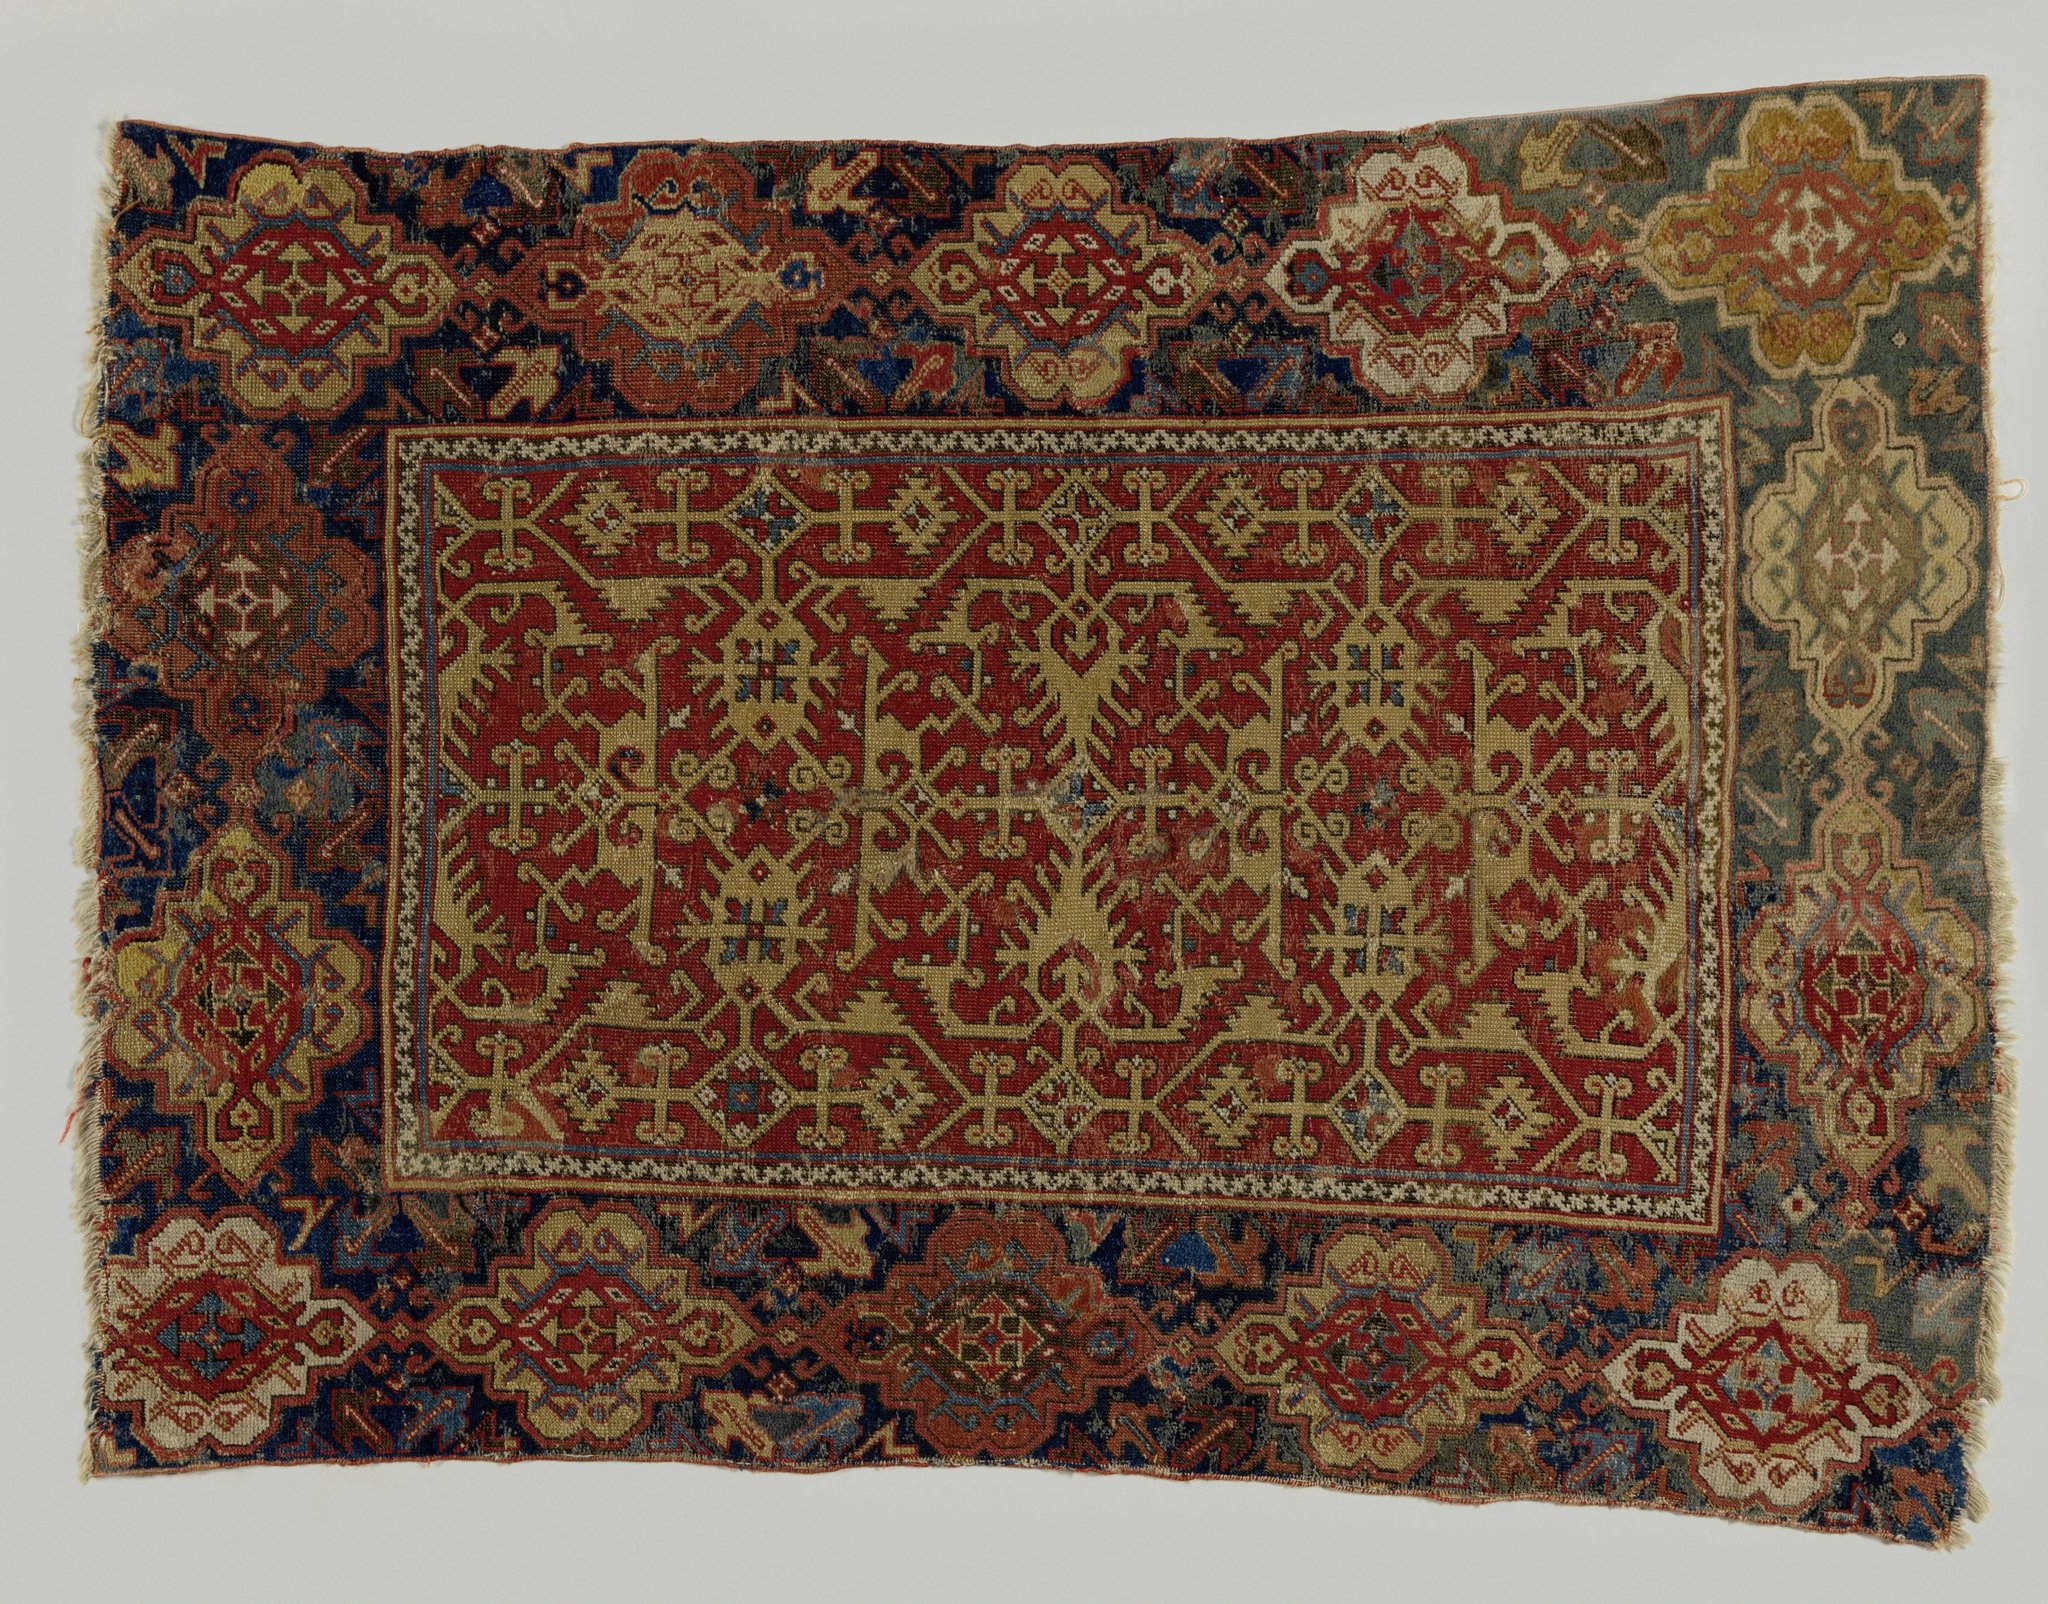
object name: oriental rug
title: Oosters tapijt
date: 1600-1699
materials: wool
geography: asia minor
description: Oosters tapijt, arabeskenkleed, lottotapijt. Middenveld met gele arabeskenmotieven tegen een steenrode achtergrond. Lottopatroon uitgevoerd in de kelim stijl. Tweevoudige rand, waarvan de brede versierd is met gelijkvormige cartouches. Knoop: Ghiordes knoop.